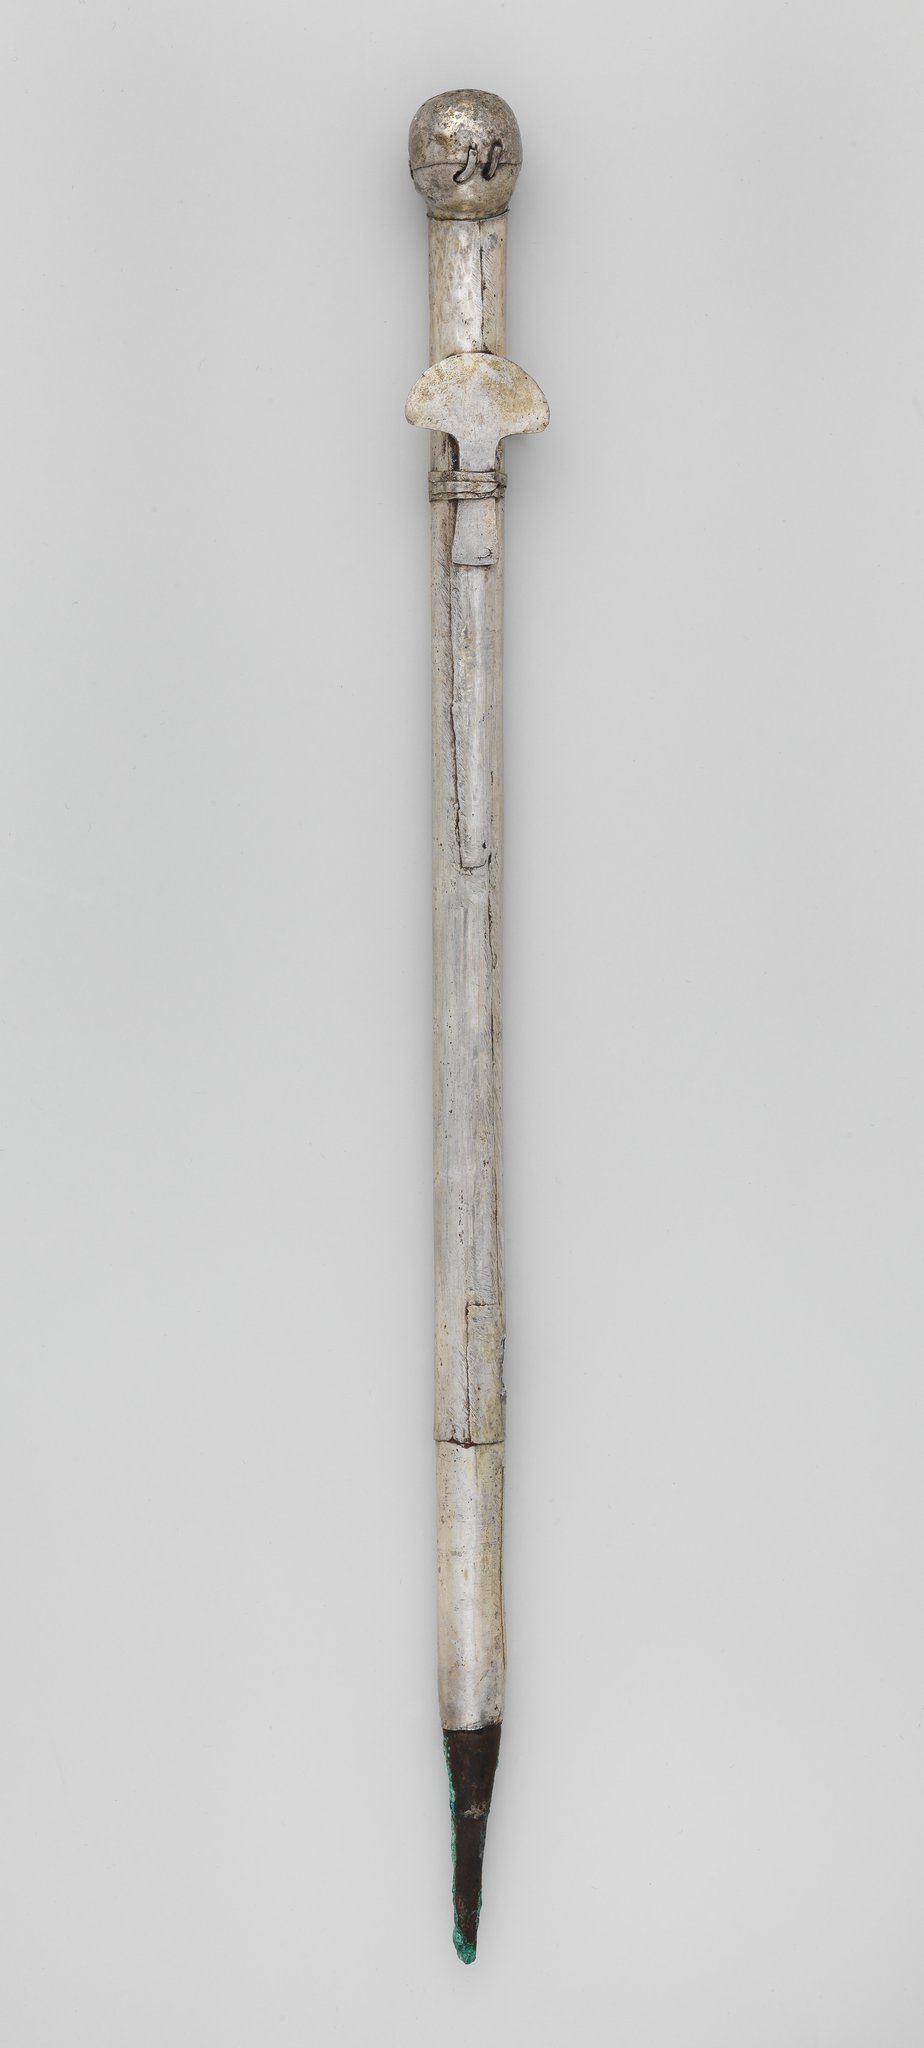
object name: stick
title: Miniature club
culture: chancay or chimú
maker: chimú or chancay artist(s)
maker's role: artist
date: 1300-1470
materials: copper, silver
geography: peru